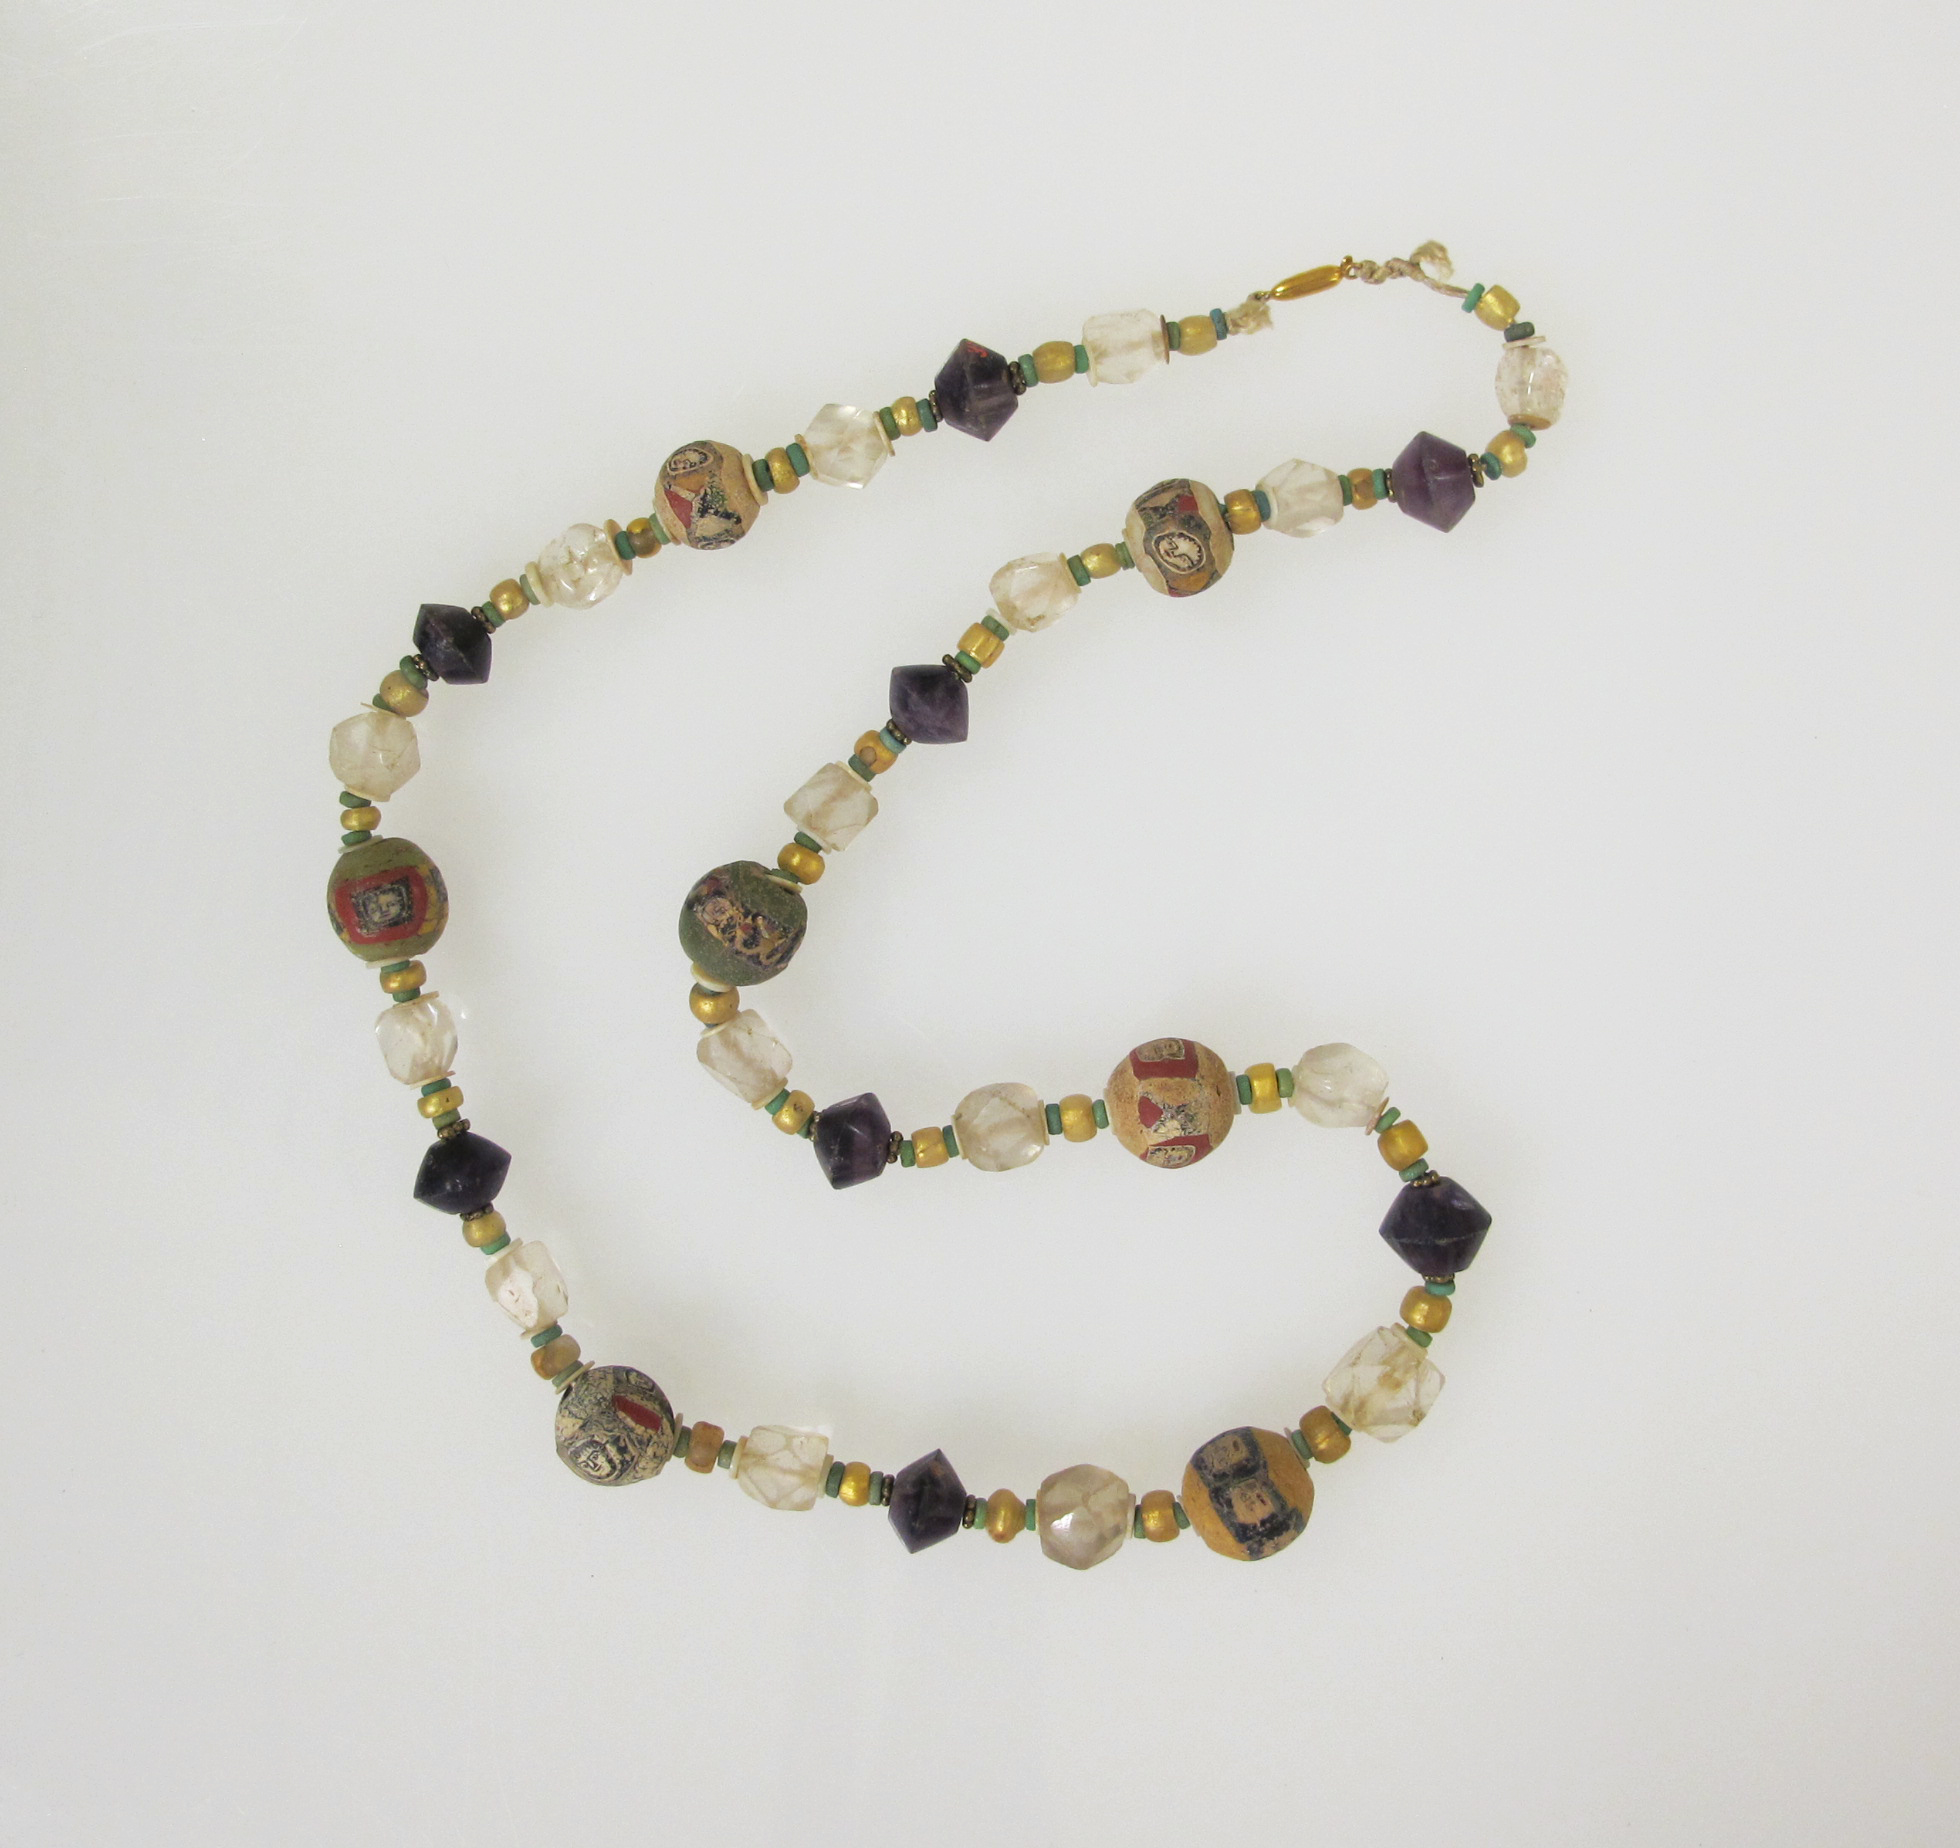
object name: necklace with 187 bead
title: Glass necklace comprising 187 beads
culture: roman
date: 67-100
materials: glass